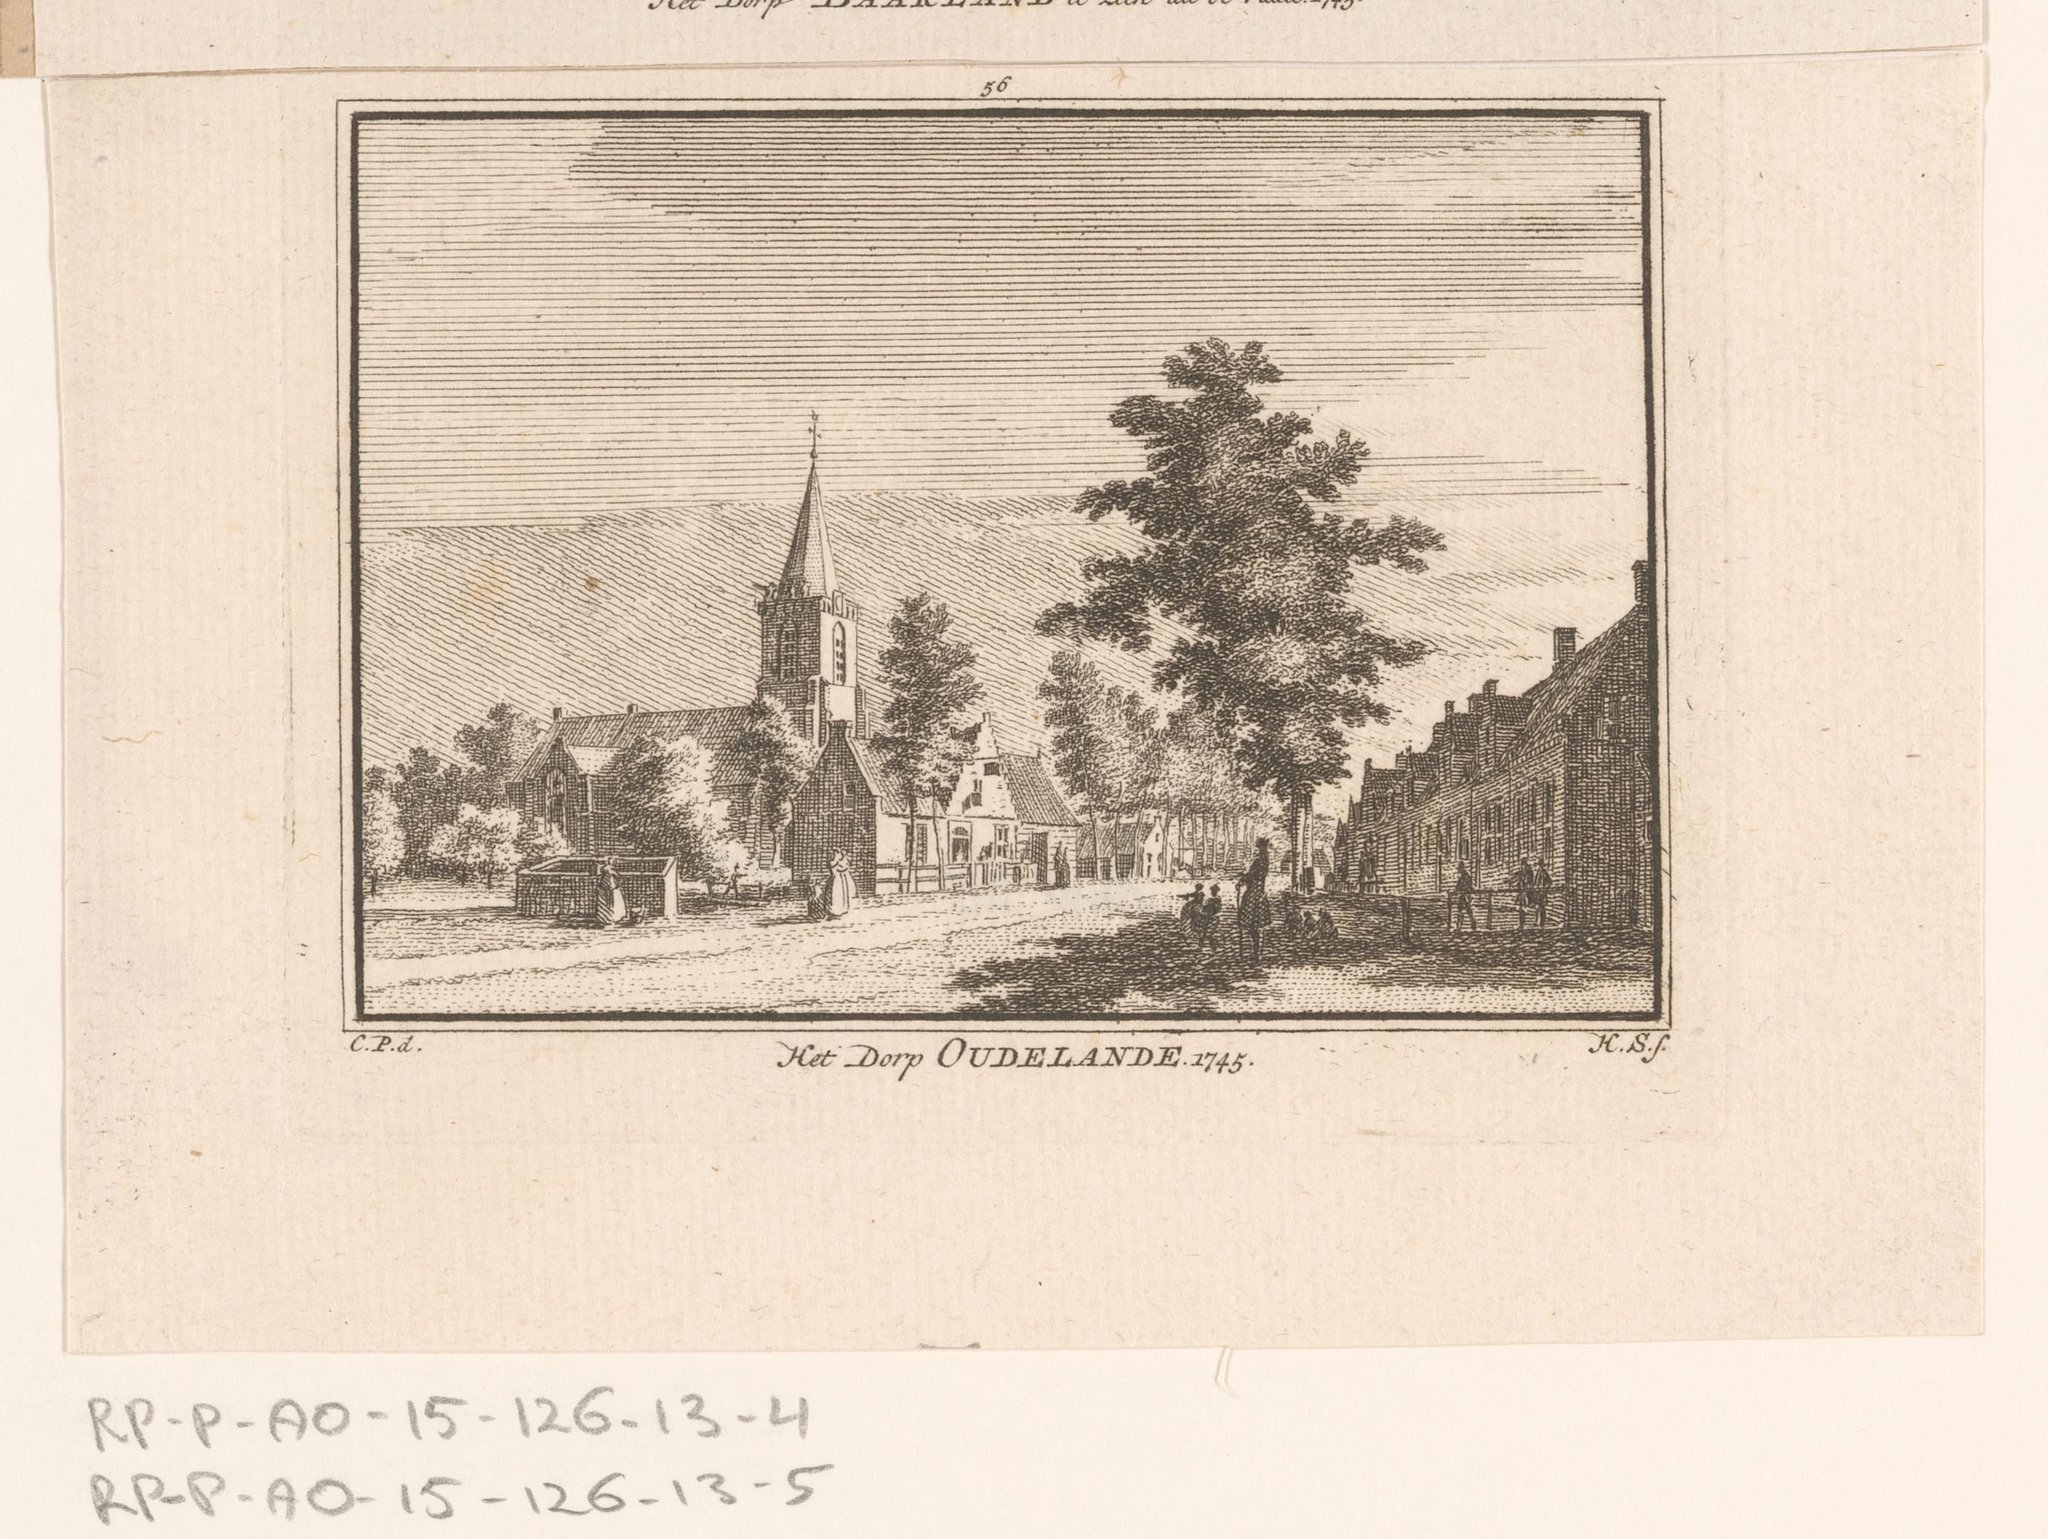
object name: print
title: Het dorp Oudelande. 1745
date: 1754-1792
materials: paper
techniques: etching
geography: haarlem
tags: prospect of village, silhouette of village, church (exterior)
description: Prent ook gebruikt in: Het verheerlykt Nederland of kabinet van hedendaagsche gezigten van steden, dorpen (…). 9 delen. Amsterdam: Isaak Tirion en weduwe Isaak Tirion, 1745-1774, dl. 5 (1754), ill. 56. Of in: Nederlandsche tafereelen; of eene keurige verzameling van negen honderd fraaije gezigten van steden, dorpen, sloten, oudheden [….]. 9 delen. Amsterdam: Jan de Groot, 1792, dl. 5, ill. 56.